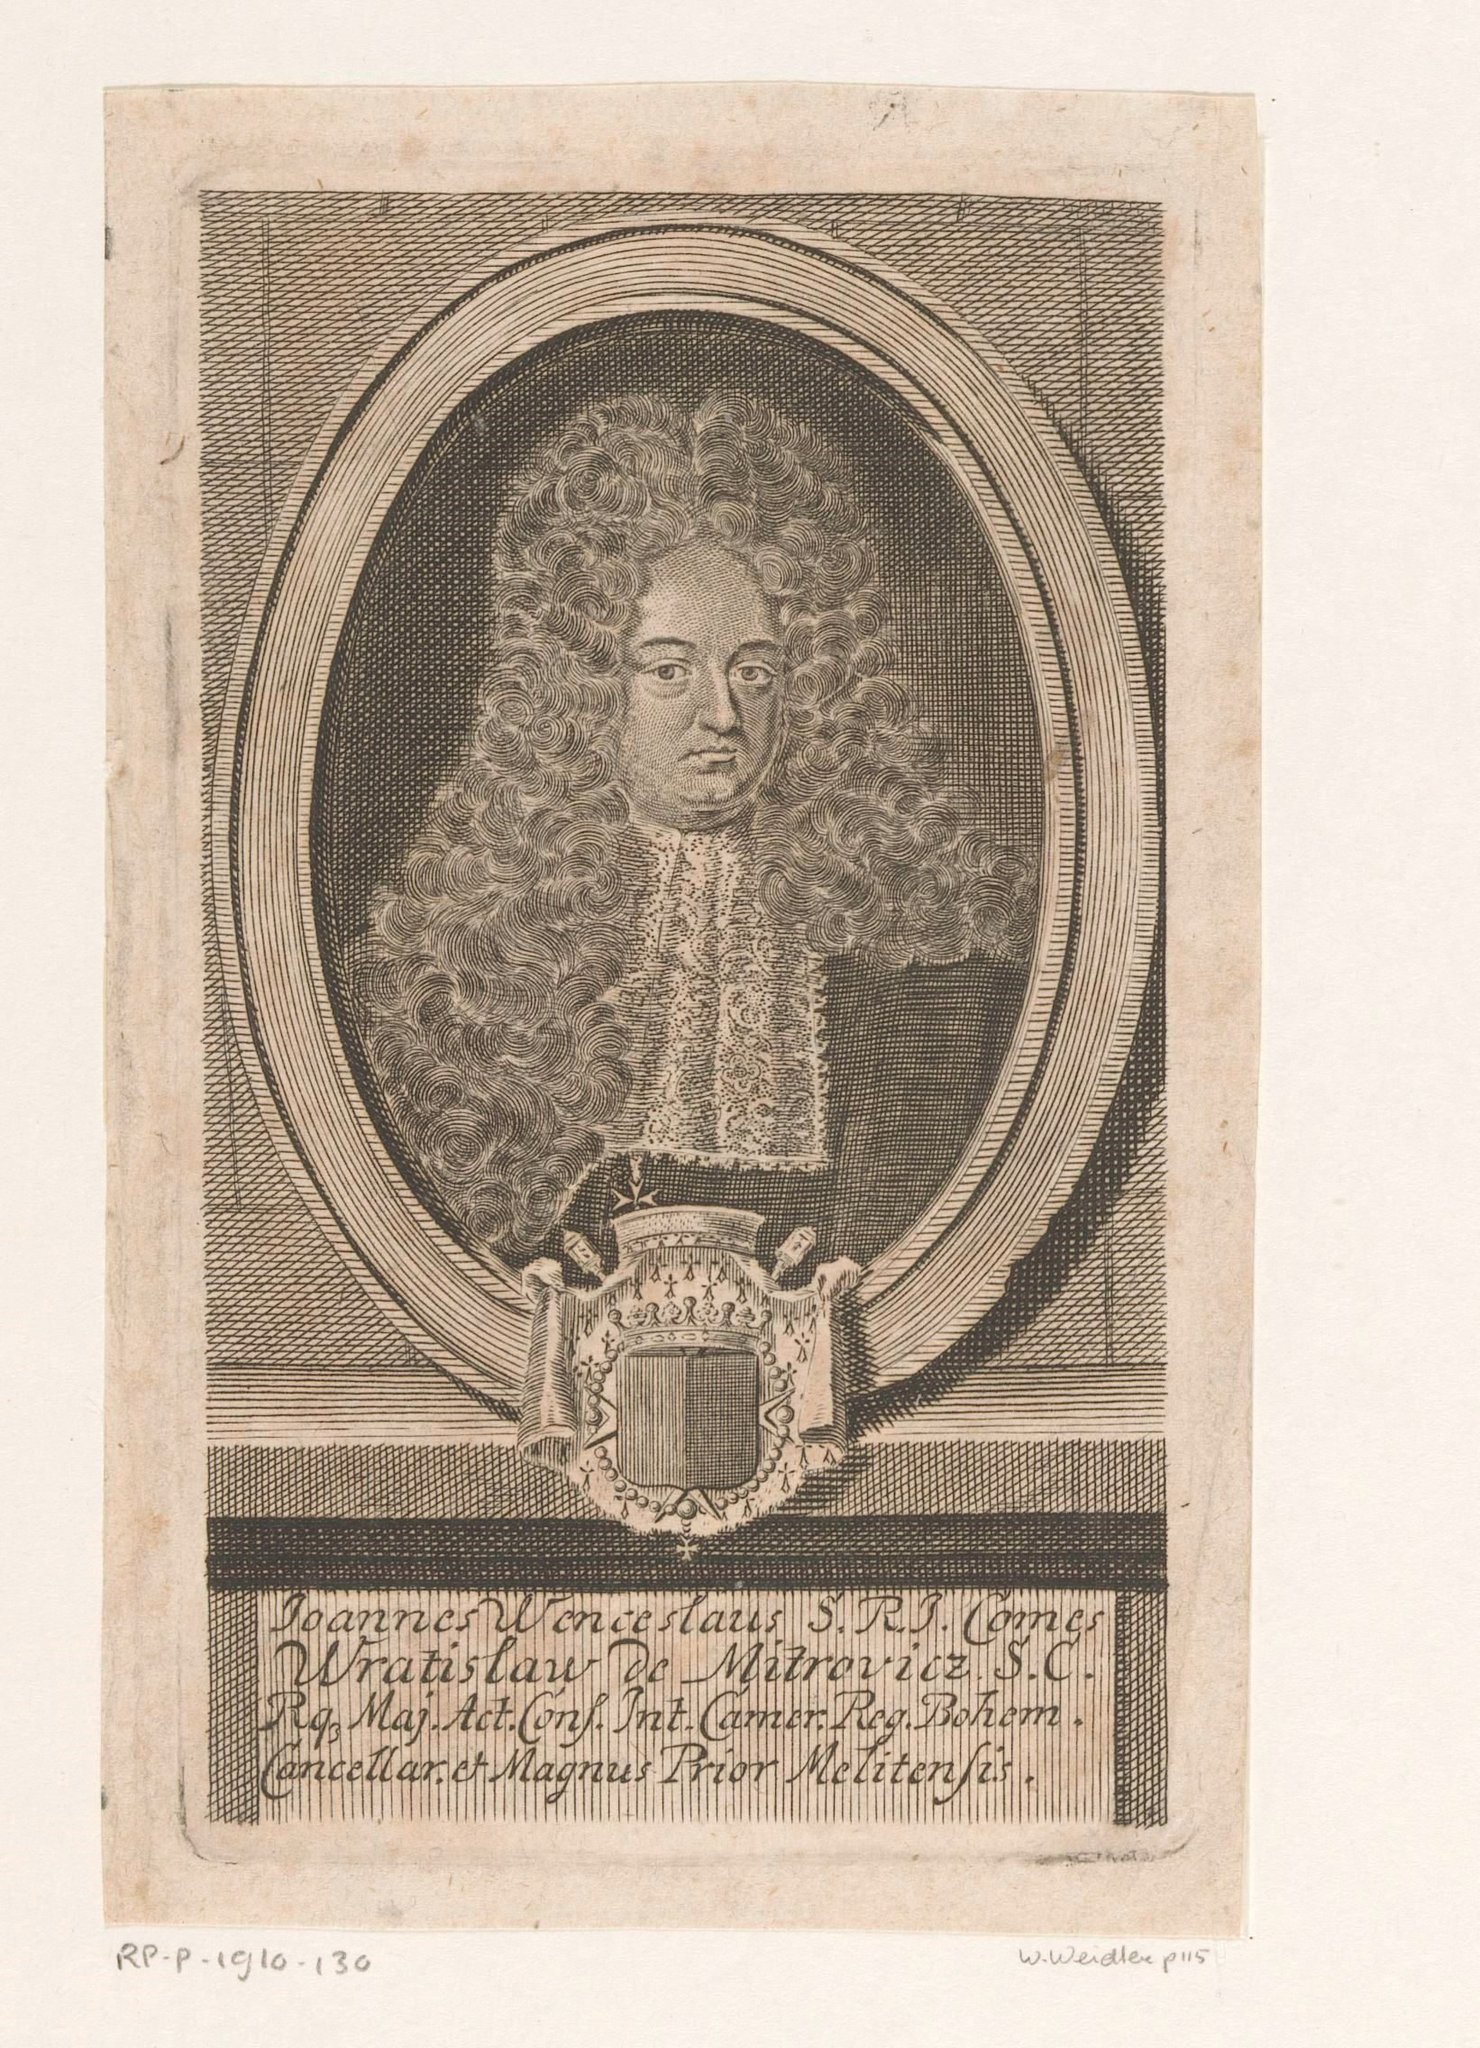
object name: print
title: Portret van Johann Wenzel Graf von Wratislaw und Mitrowitz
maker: martin bernigeroth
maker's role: print maker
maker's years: 1670-1733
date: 1711-1733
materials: paper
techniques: engraving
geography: leipzig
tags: prague, historical persons, armorial bearing, heraldry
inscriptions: collector's mark: Lugt 2228